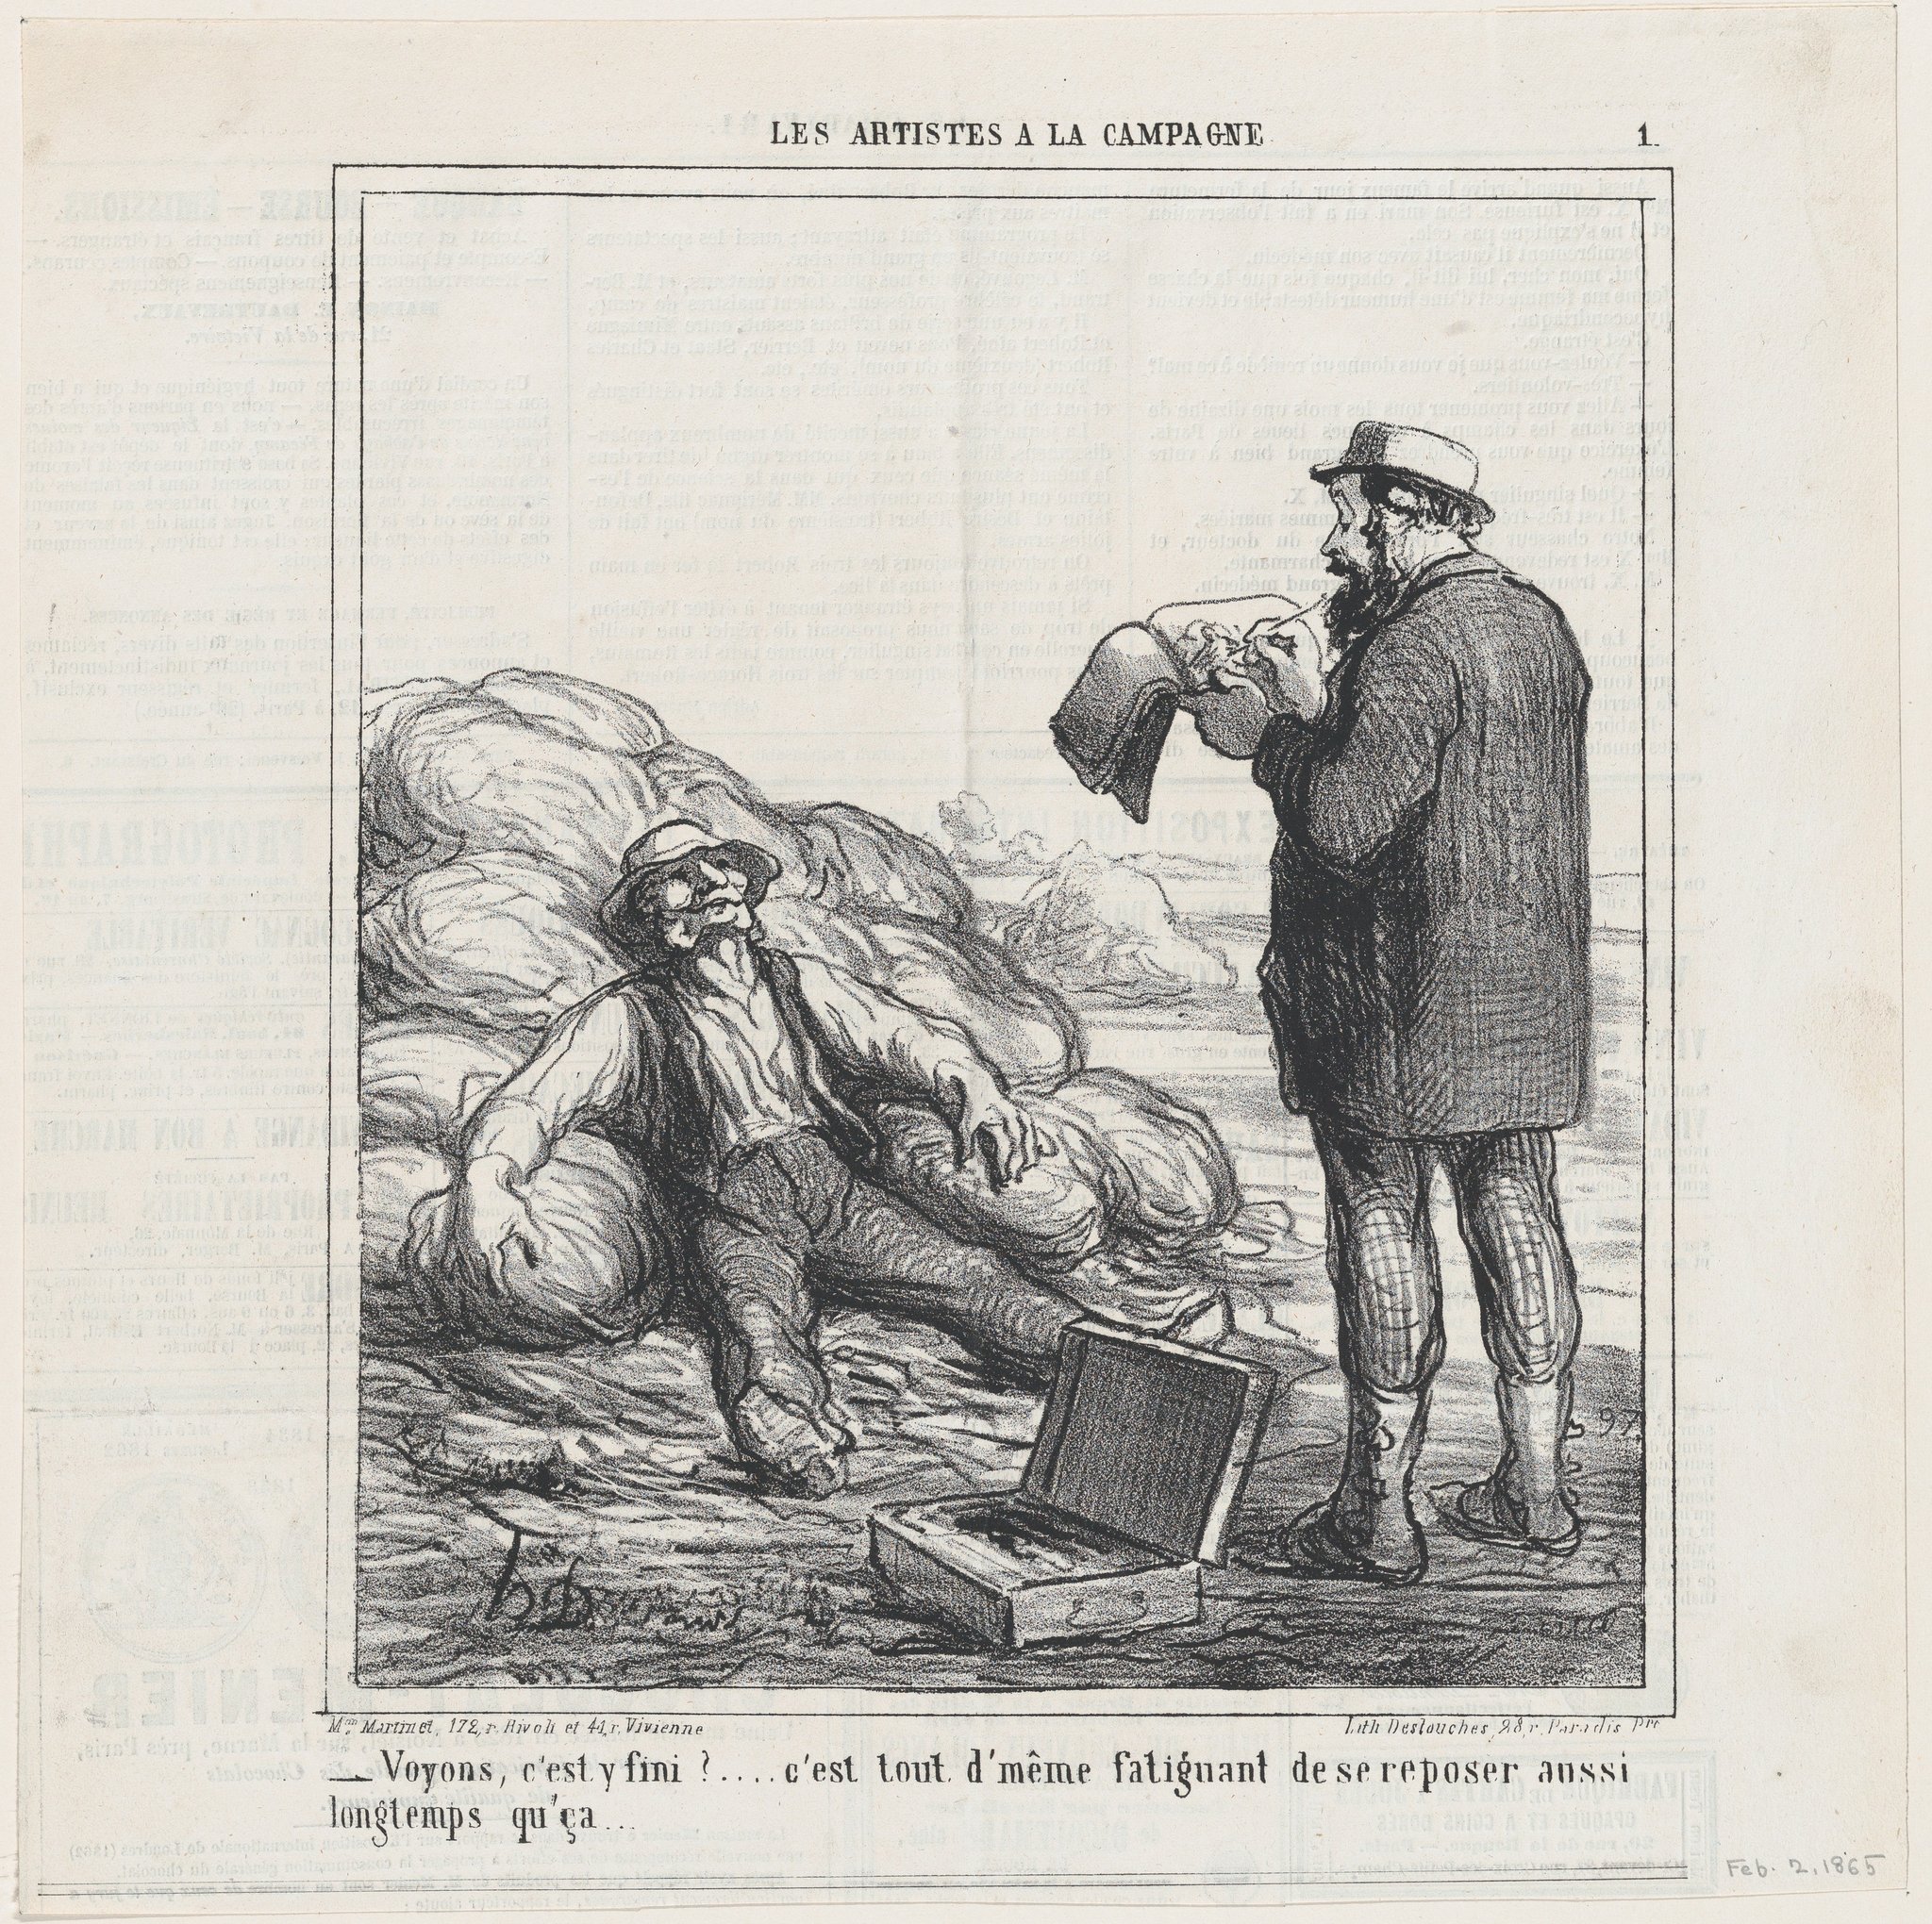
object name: print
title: Well, are you finally finished?... after all, it's tiring to relax for such a long time, from 'The countryside artists,' published in Le Charivari, February 2, 1865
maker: honoré daumier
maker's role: artist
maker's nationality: french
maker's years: 1808-1879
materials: paper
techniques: lithograph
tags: satire,men,artists